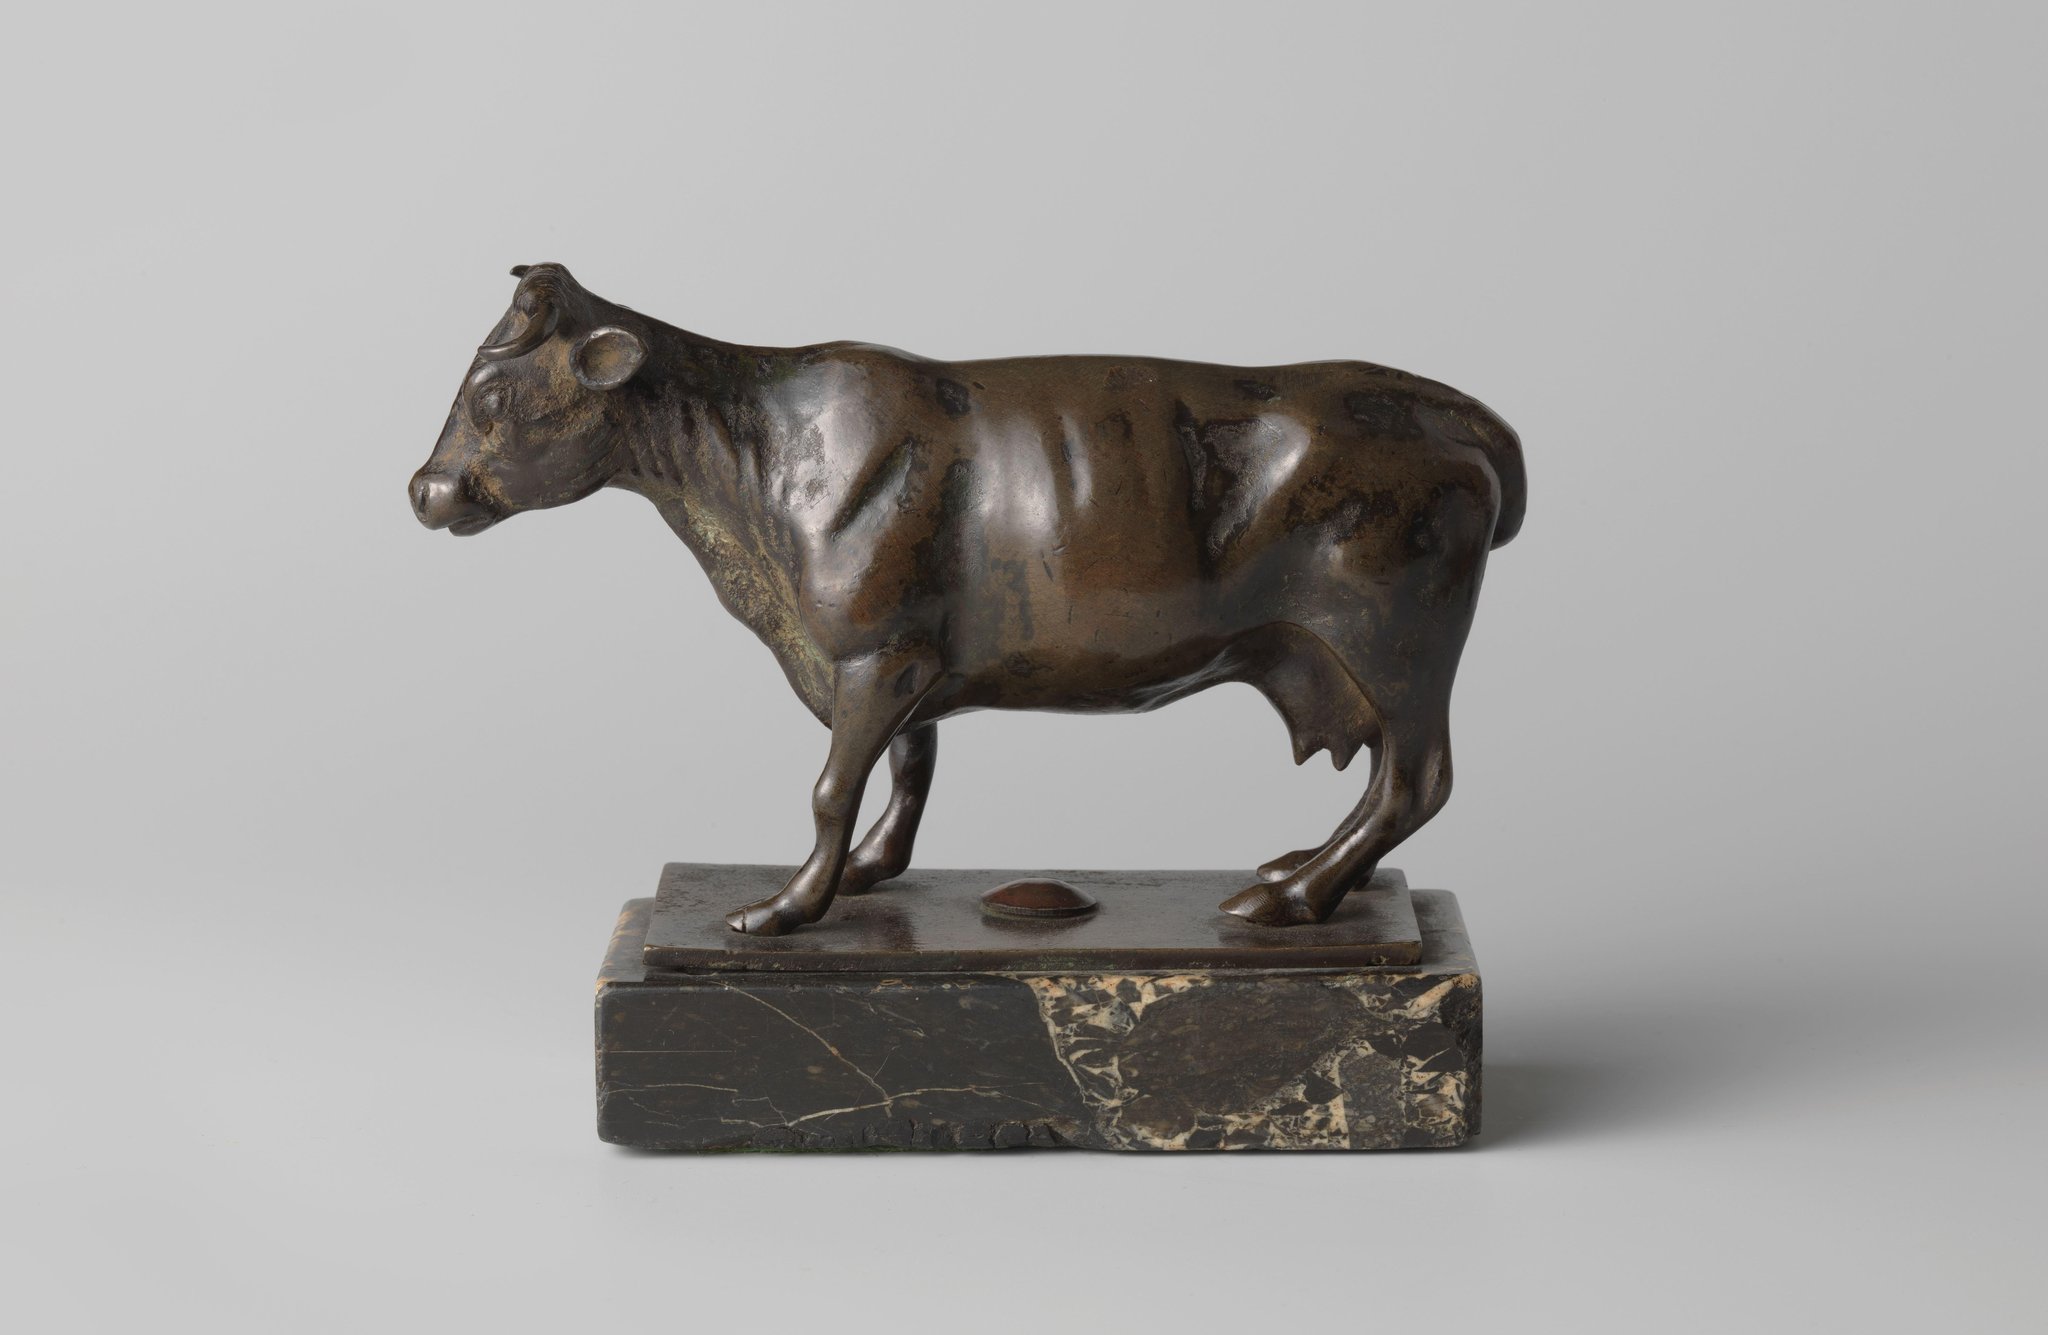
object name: sculpture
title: Cow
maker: Anonymous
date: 1675-1750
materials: bronze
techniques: casting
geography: northern netherlands